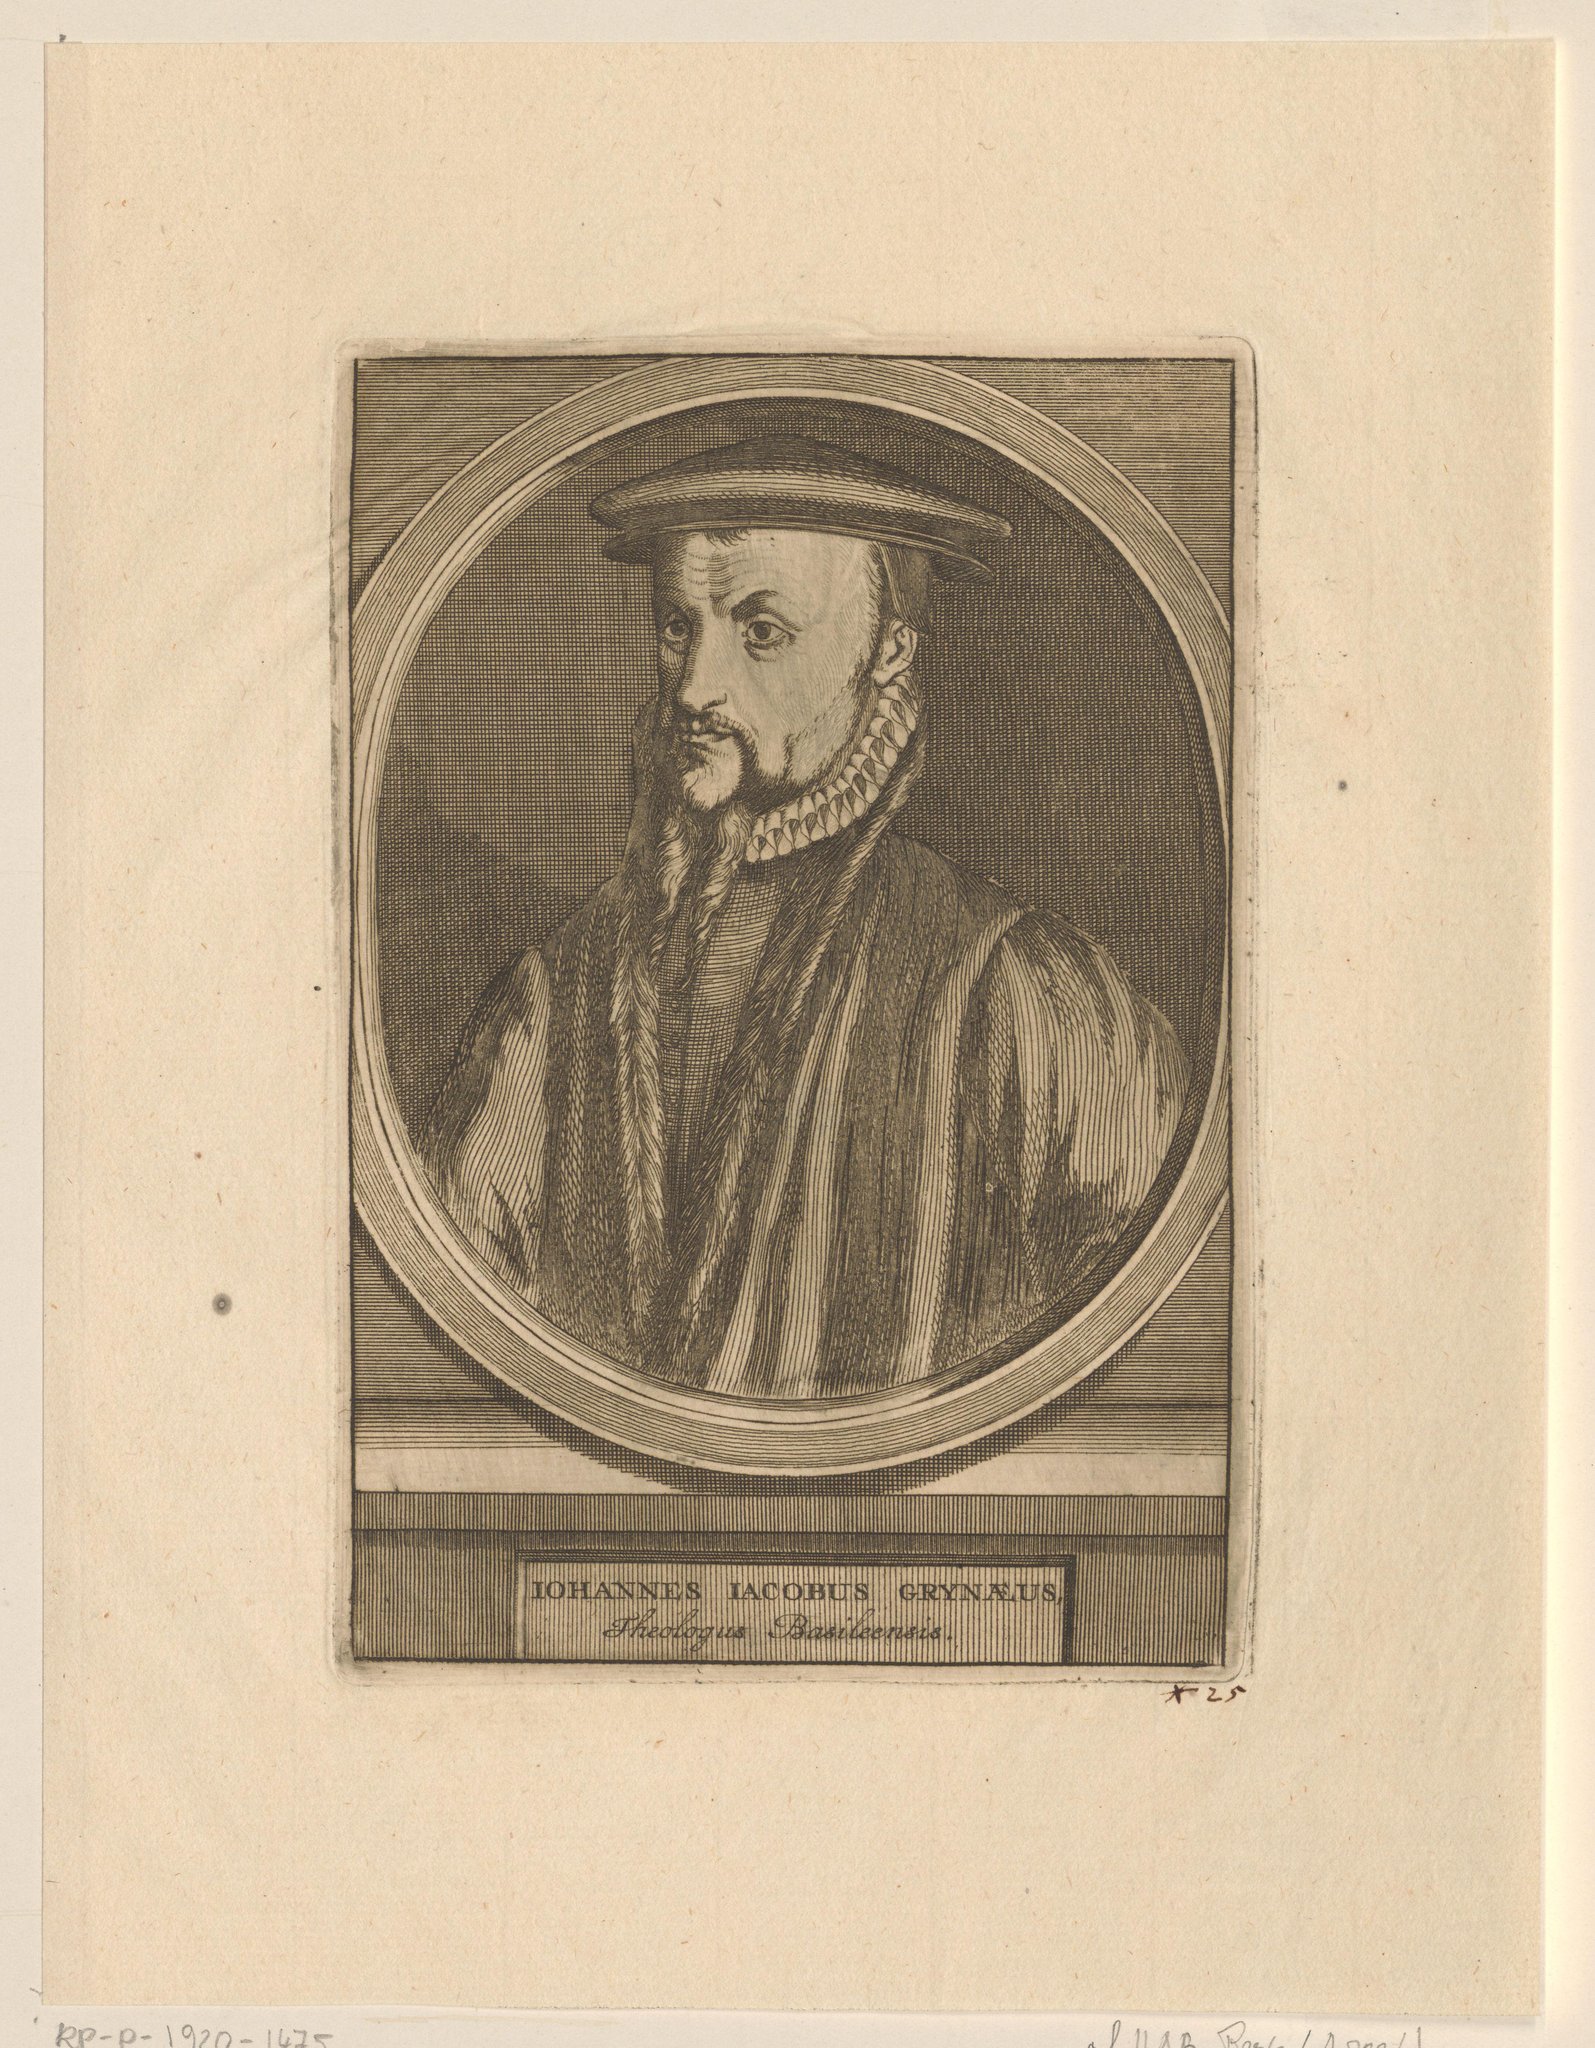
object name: print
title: Portret van Johann Jakob Grynaeus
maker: Anonymous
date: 1600-1700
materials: paper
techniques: engraving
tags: theologian, historical persons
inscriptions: collector's mark: Lugt 2228